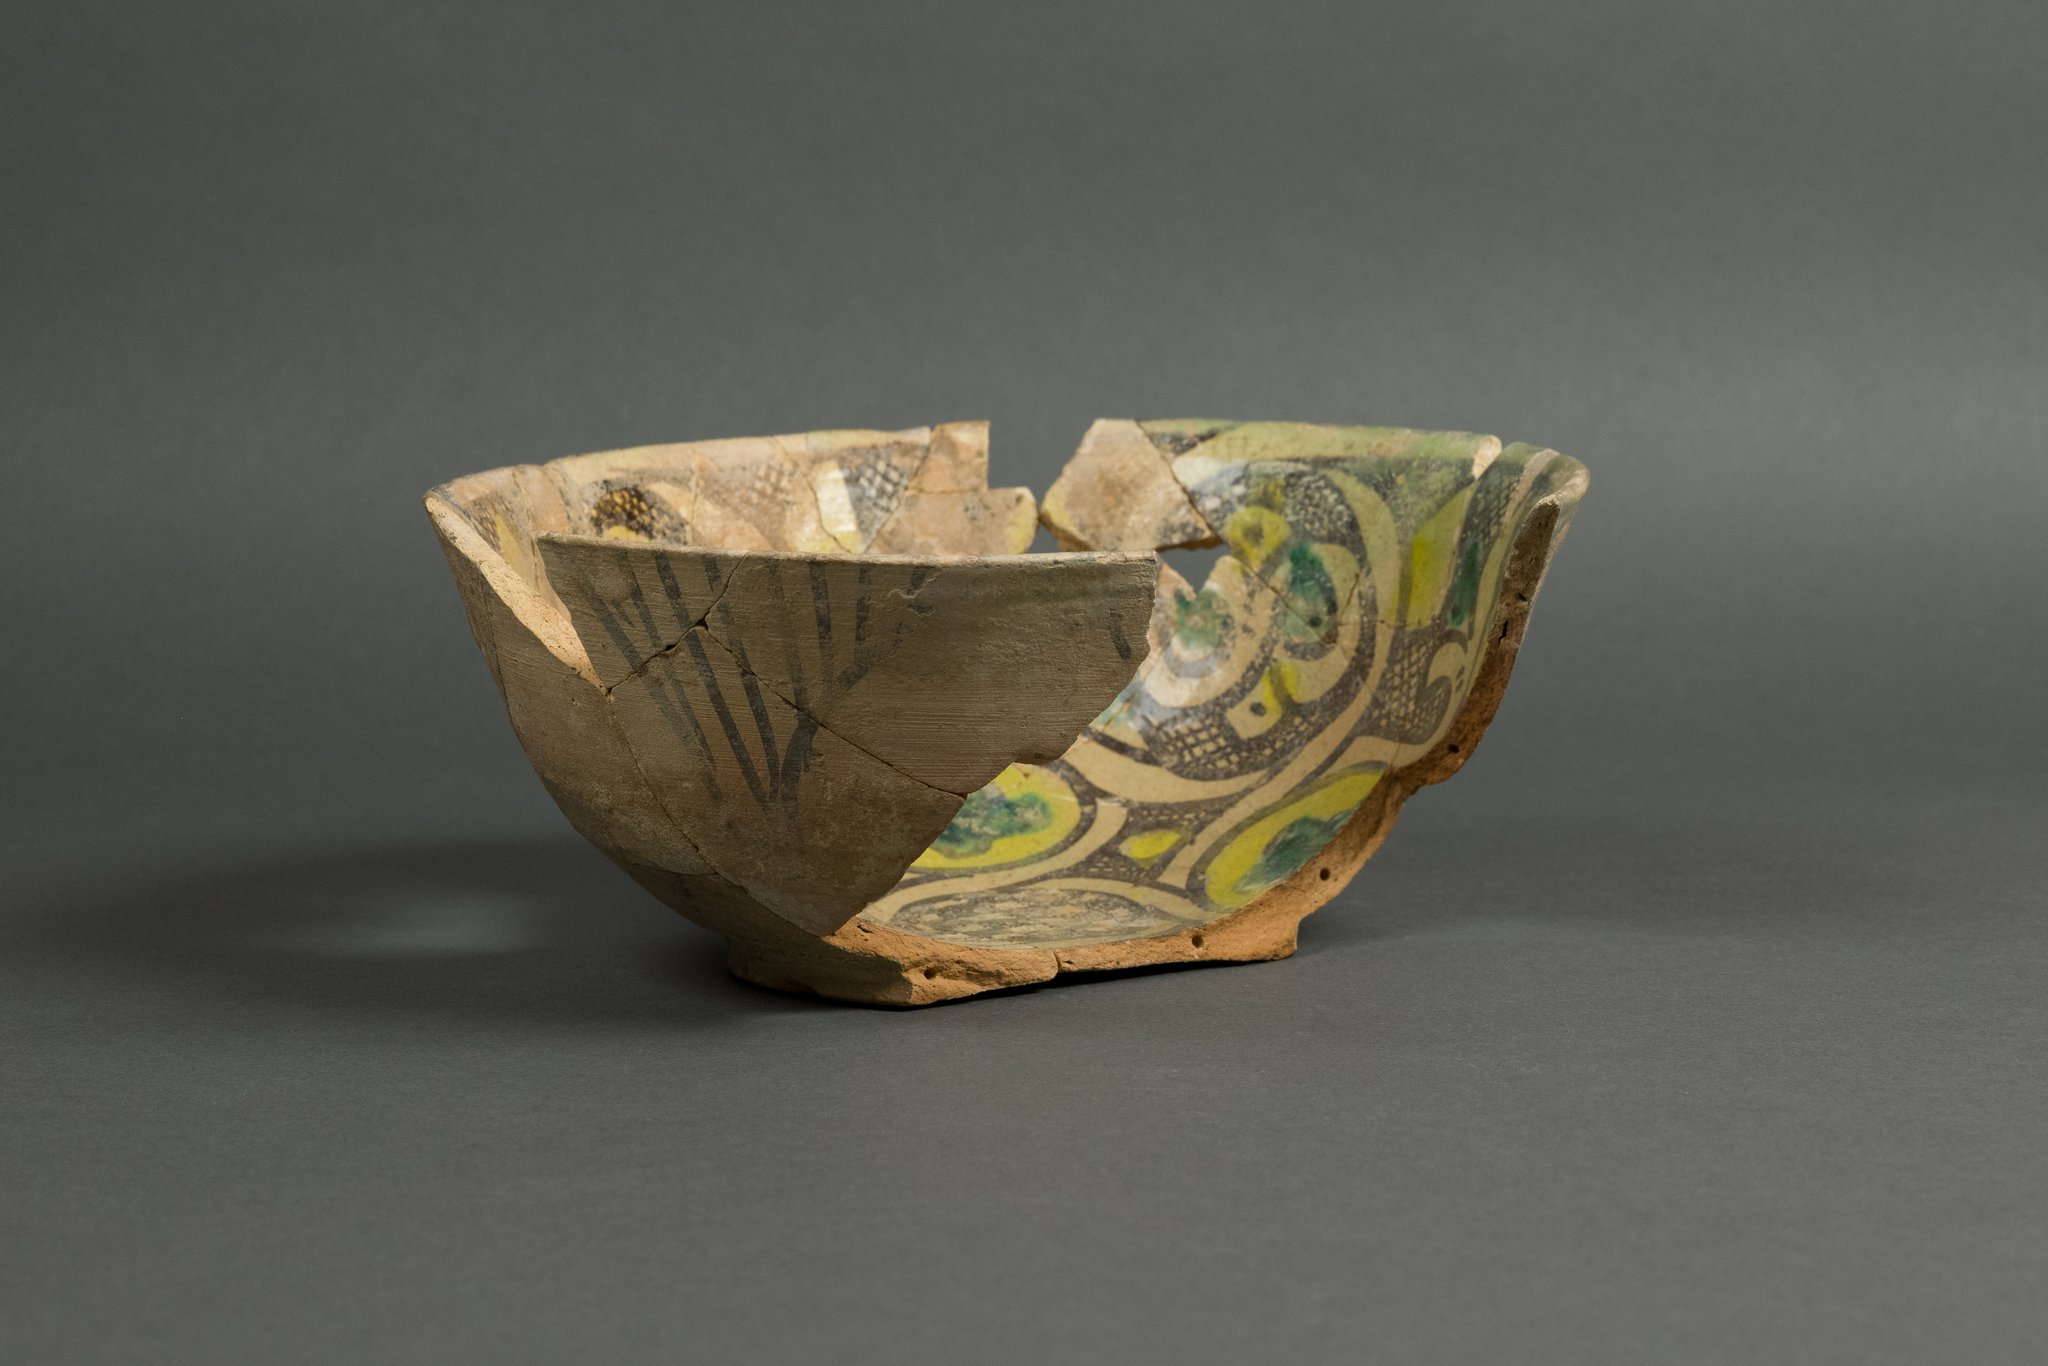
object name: bowl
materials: earthenware, glaze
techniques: polychrome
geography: iran